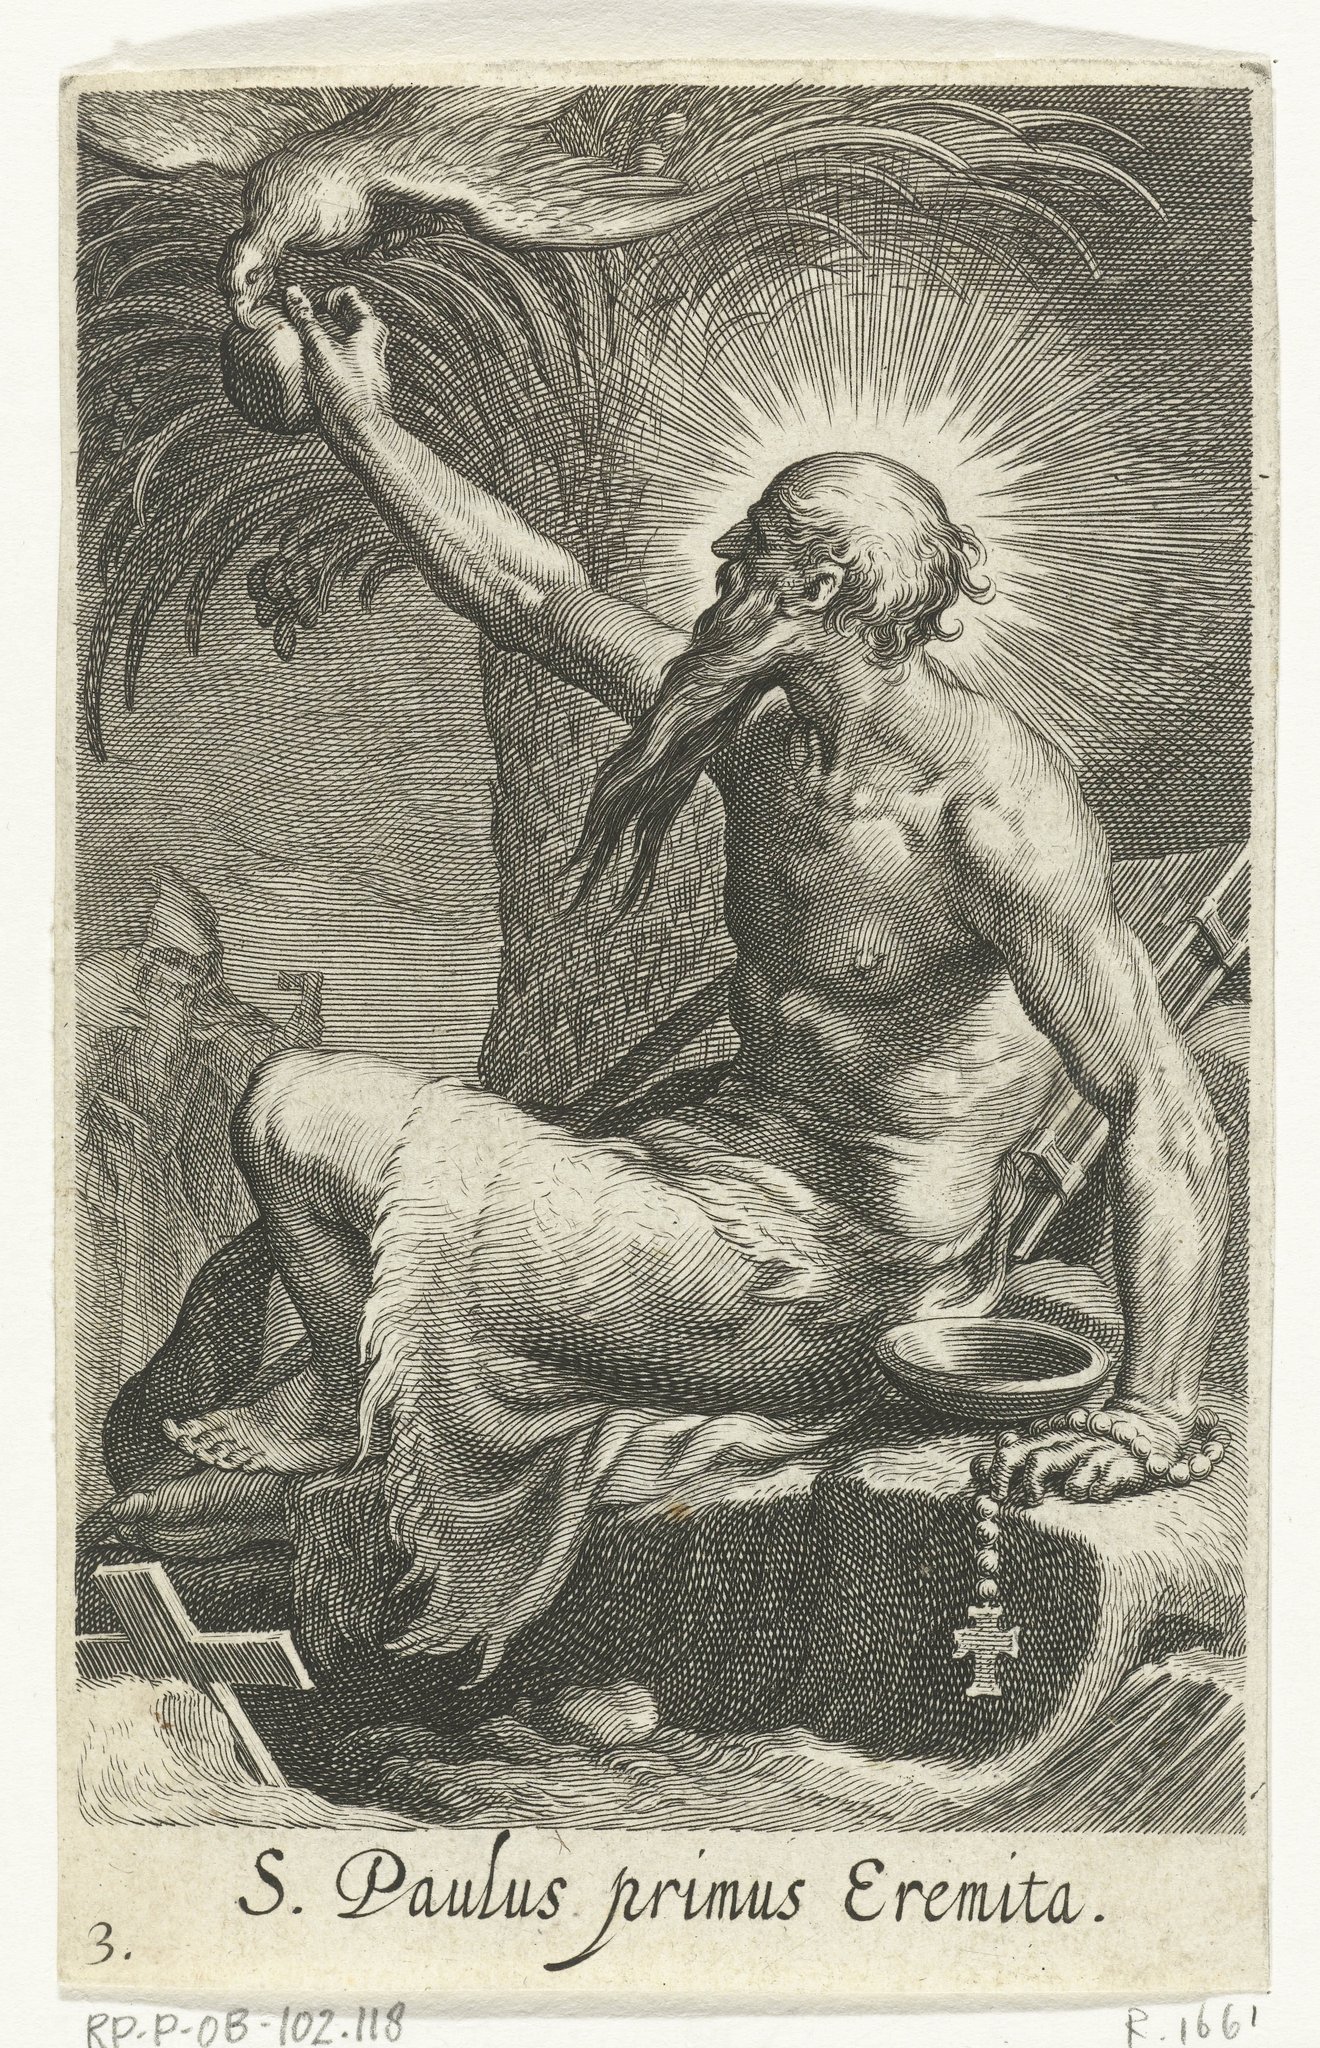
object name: print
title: S, Paulus primus Eremita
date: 1590-1612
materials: paper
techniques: engraving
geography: amsterdam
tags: paul of thebes, the first hermit; possible attributes: raven, two lions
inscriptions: collector's mark: Lugt 2228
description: Prent uit: Sacra eremus ascetarum, Antwerpen, Hendrick Aertssen, 1619. Eerste gebonden uitgave met in totaal vijftig prenten. Prent uit serie van vijfentwintig mannelijke kluizenaars. In 1612 verscheen een ongebonden editie maar op basis van de gewijzigde opschriften en samenstelling wordt aangenomen dat de prenten van de uitgave 1619 ook in 1612 of iets daarvoor gedrukt werden. Roethlisberger beschouwt de uitgave van 1619 als de eerste staat en de ongebonden editie van 1612 als de tweede staat (Roethlisberger 1993, p. 171, 172).